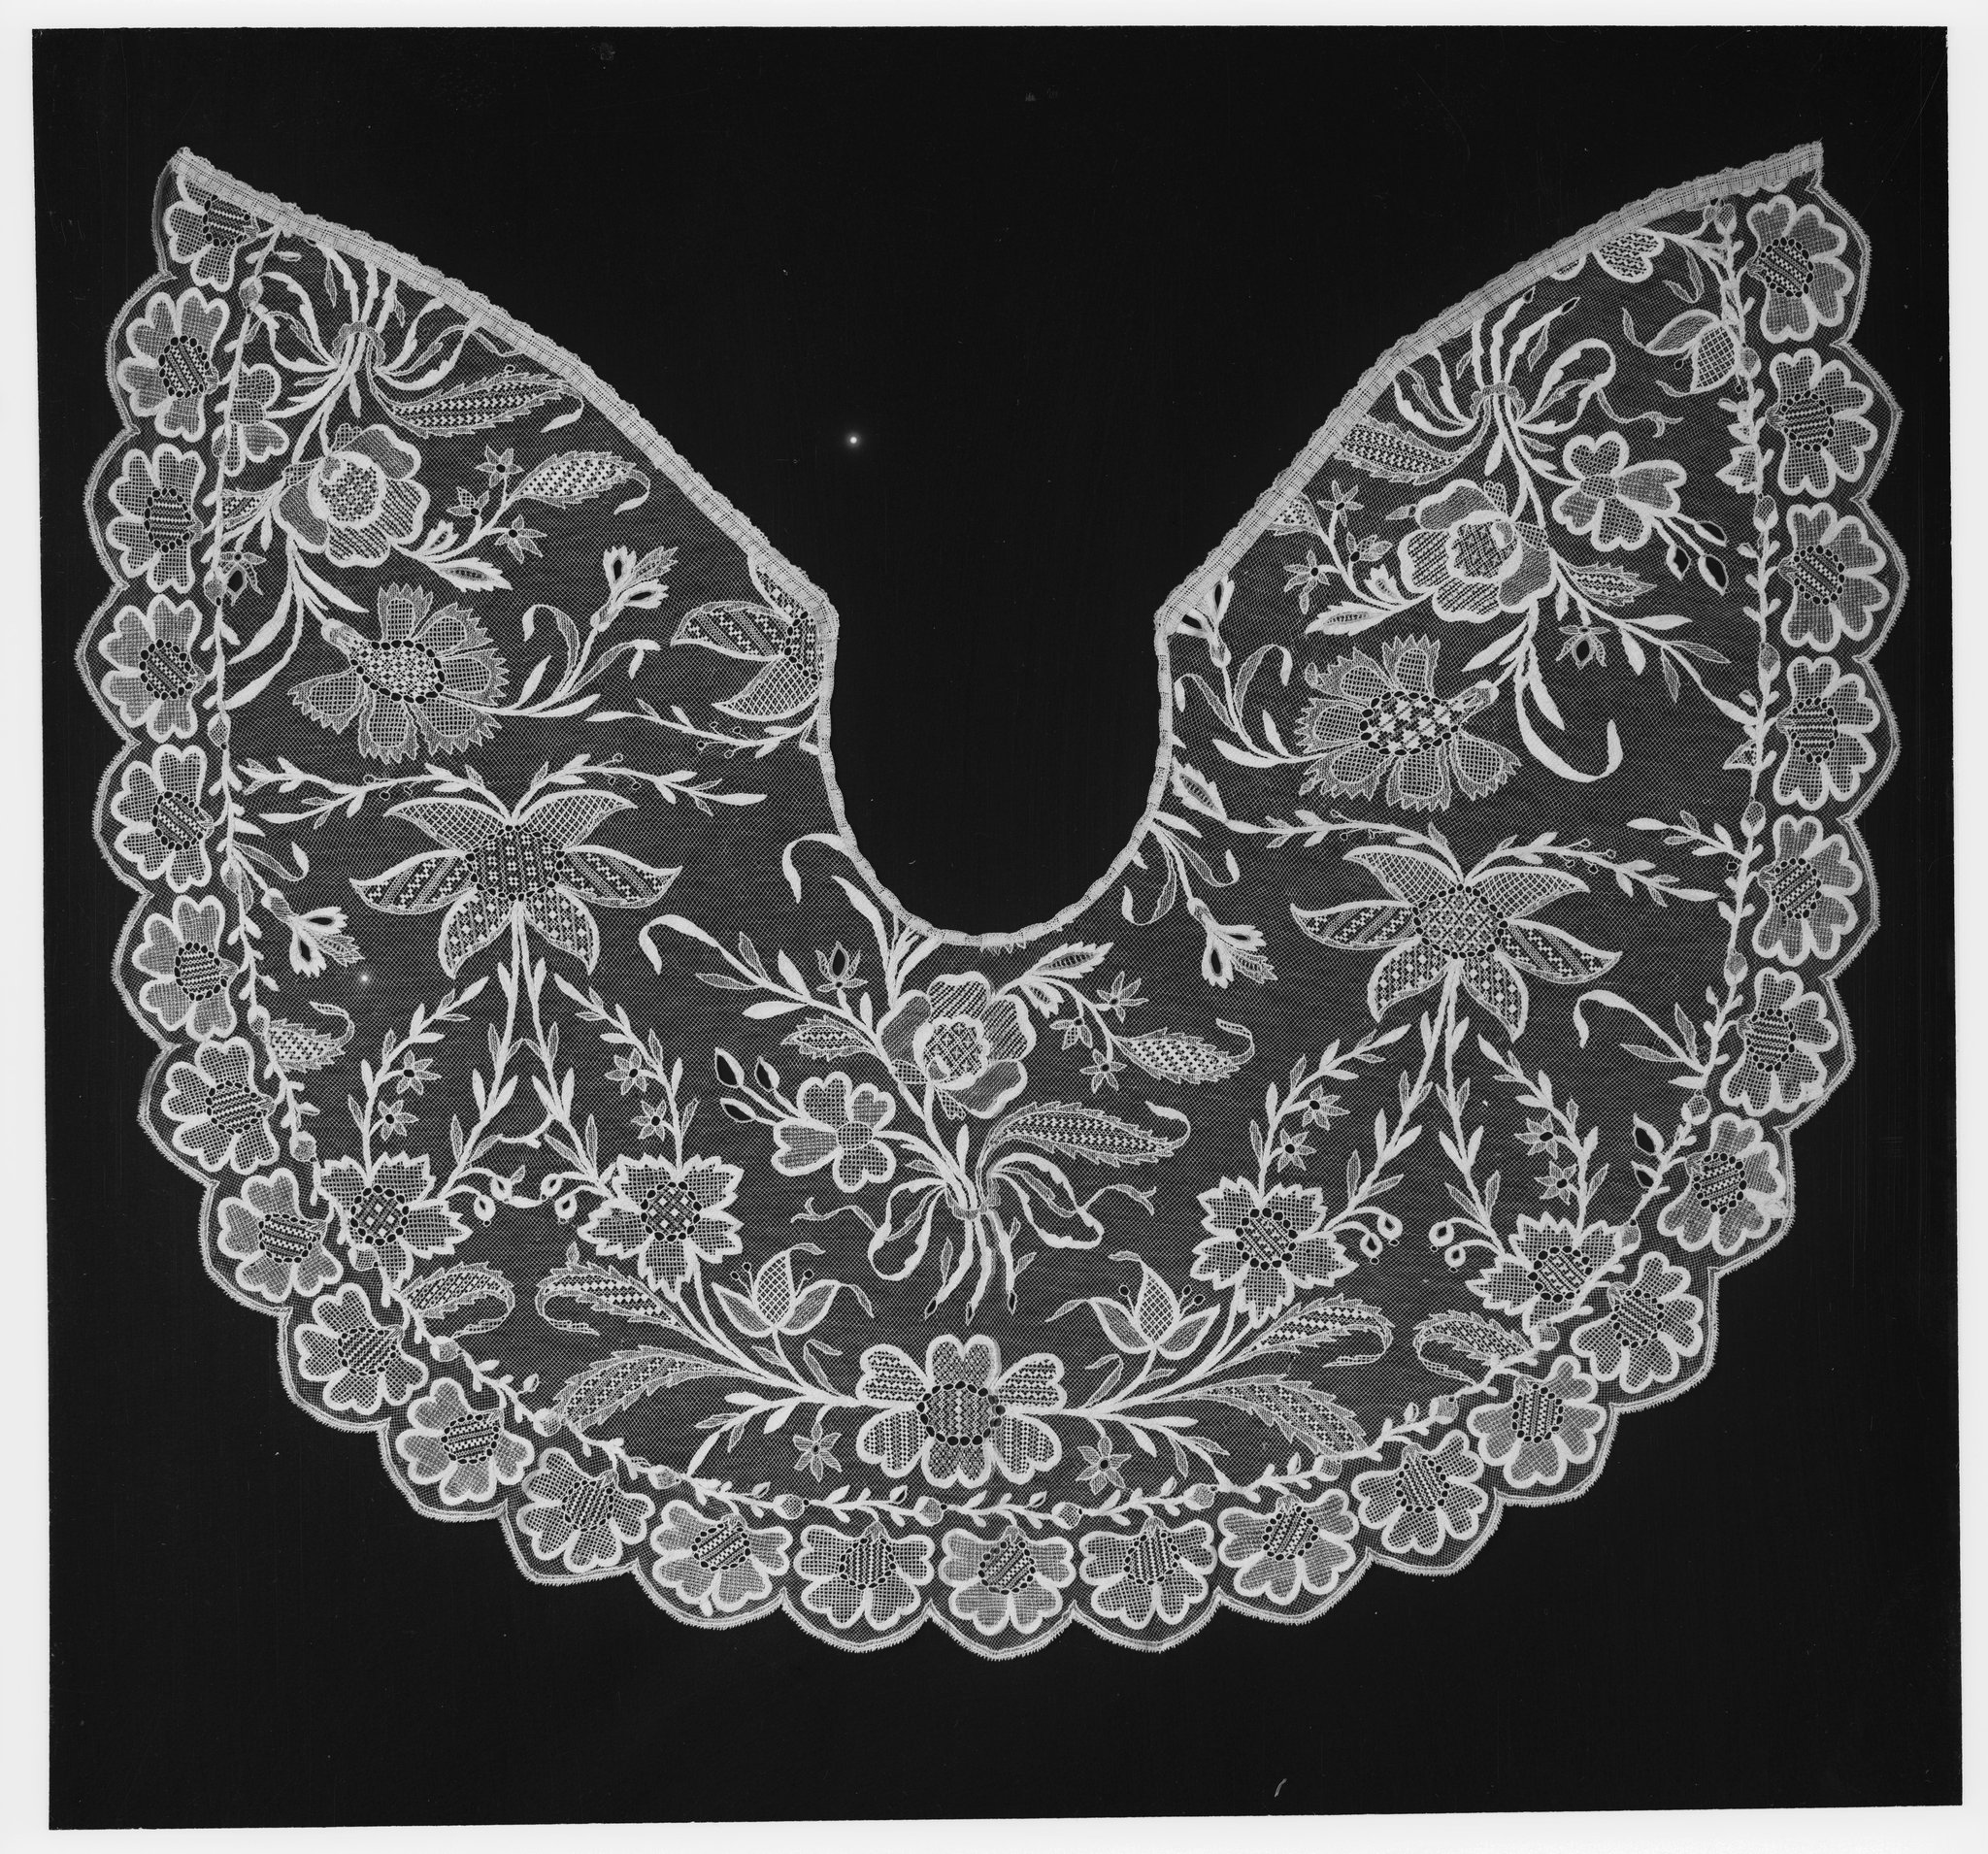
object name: collar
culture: italian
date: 1801-1900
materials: cotton, silk